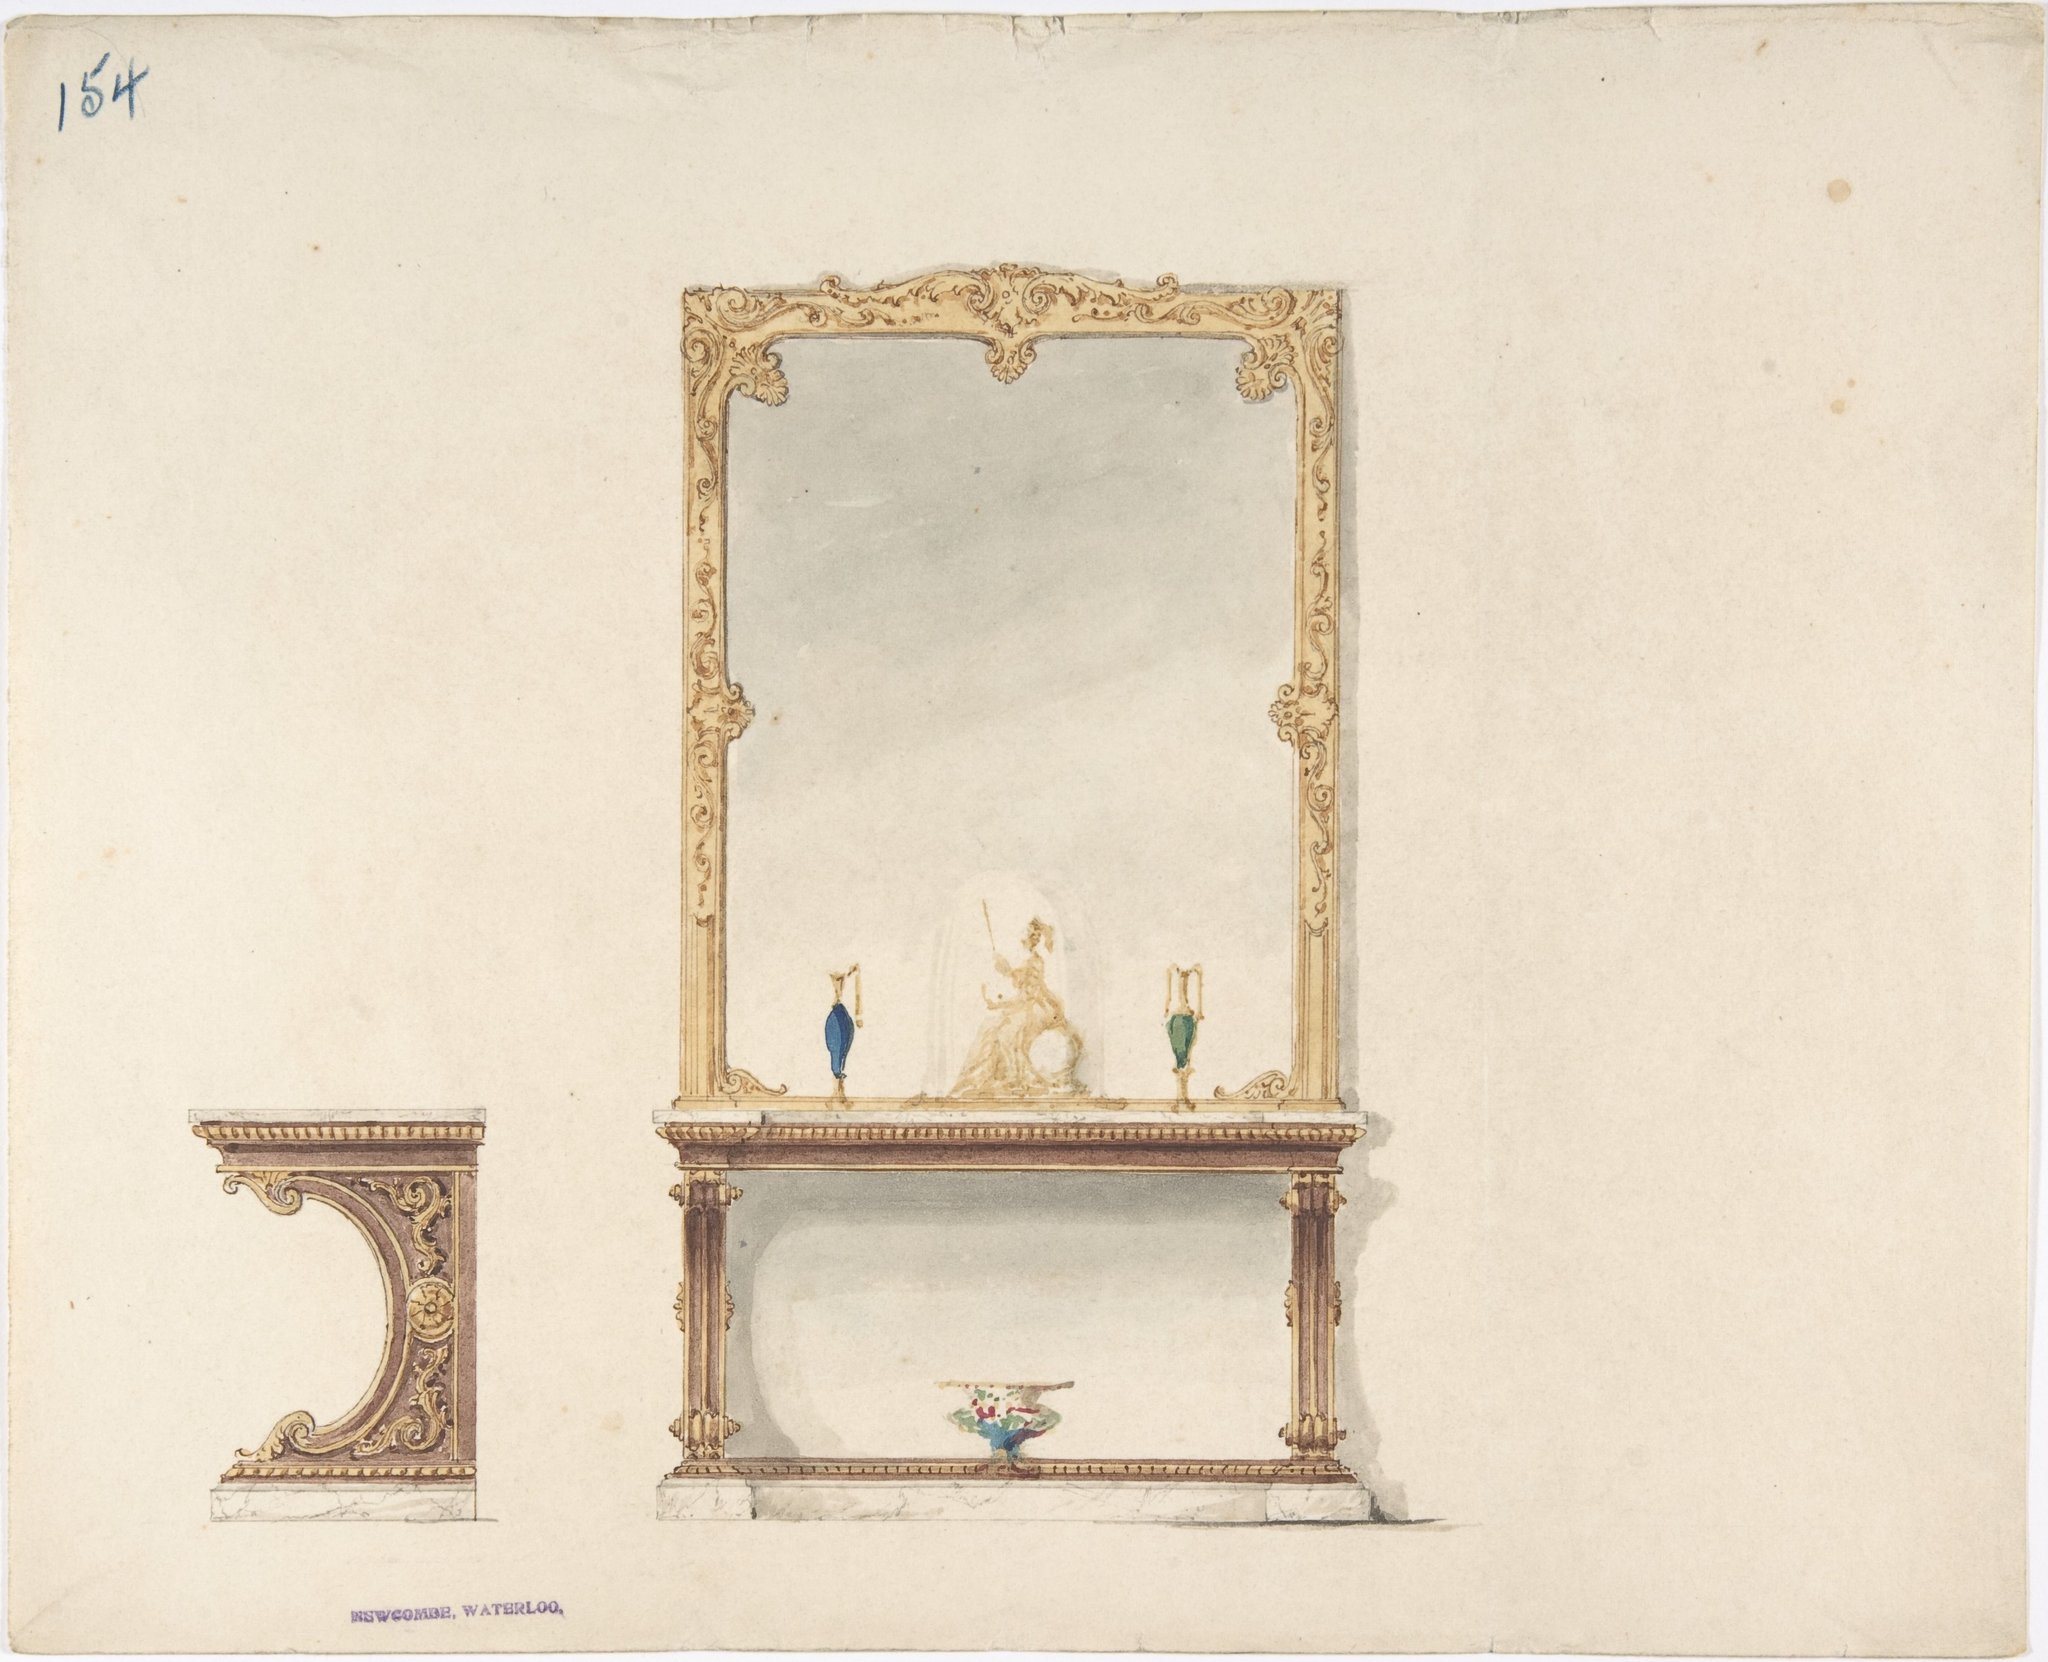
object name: drawing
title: Design for Pier Table and Gold Mirror: Front and Side Elevations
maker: anonymous, british, 19th century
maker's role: artist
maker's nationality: british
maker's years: 1800-1900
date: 1801-1833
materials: ink, watercolor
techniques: brush, pen, wash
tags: tables,mirrors